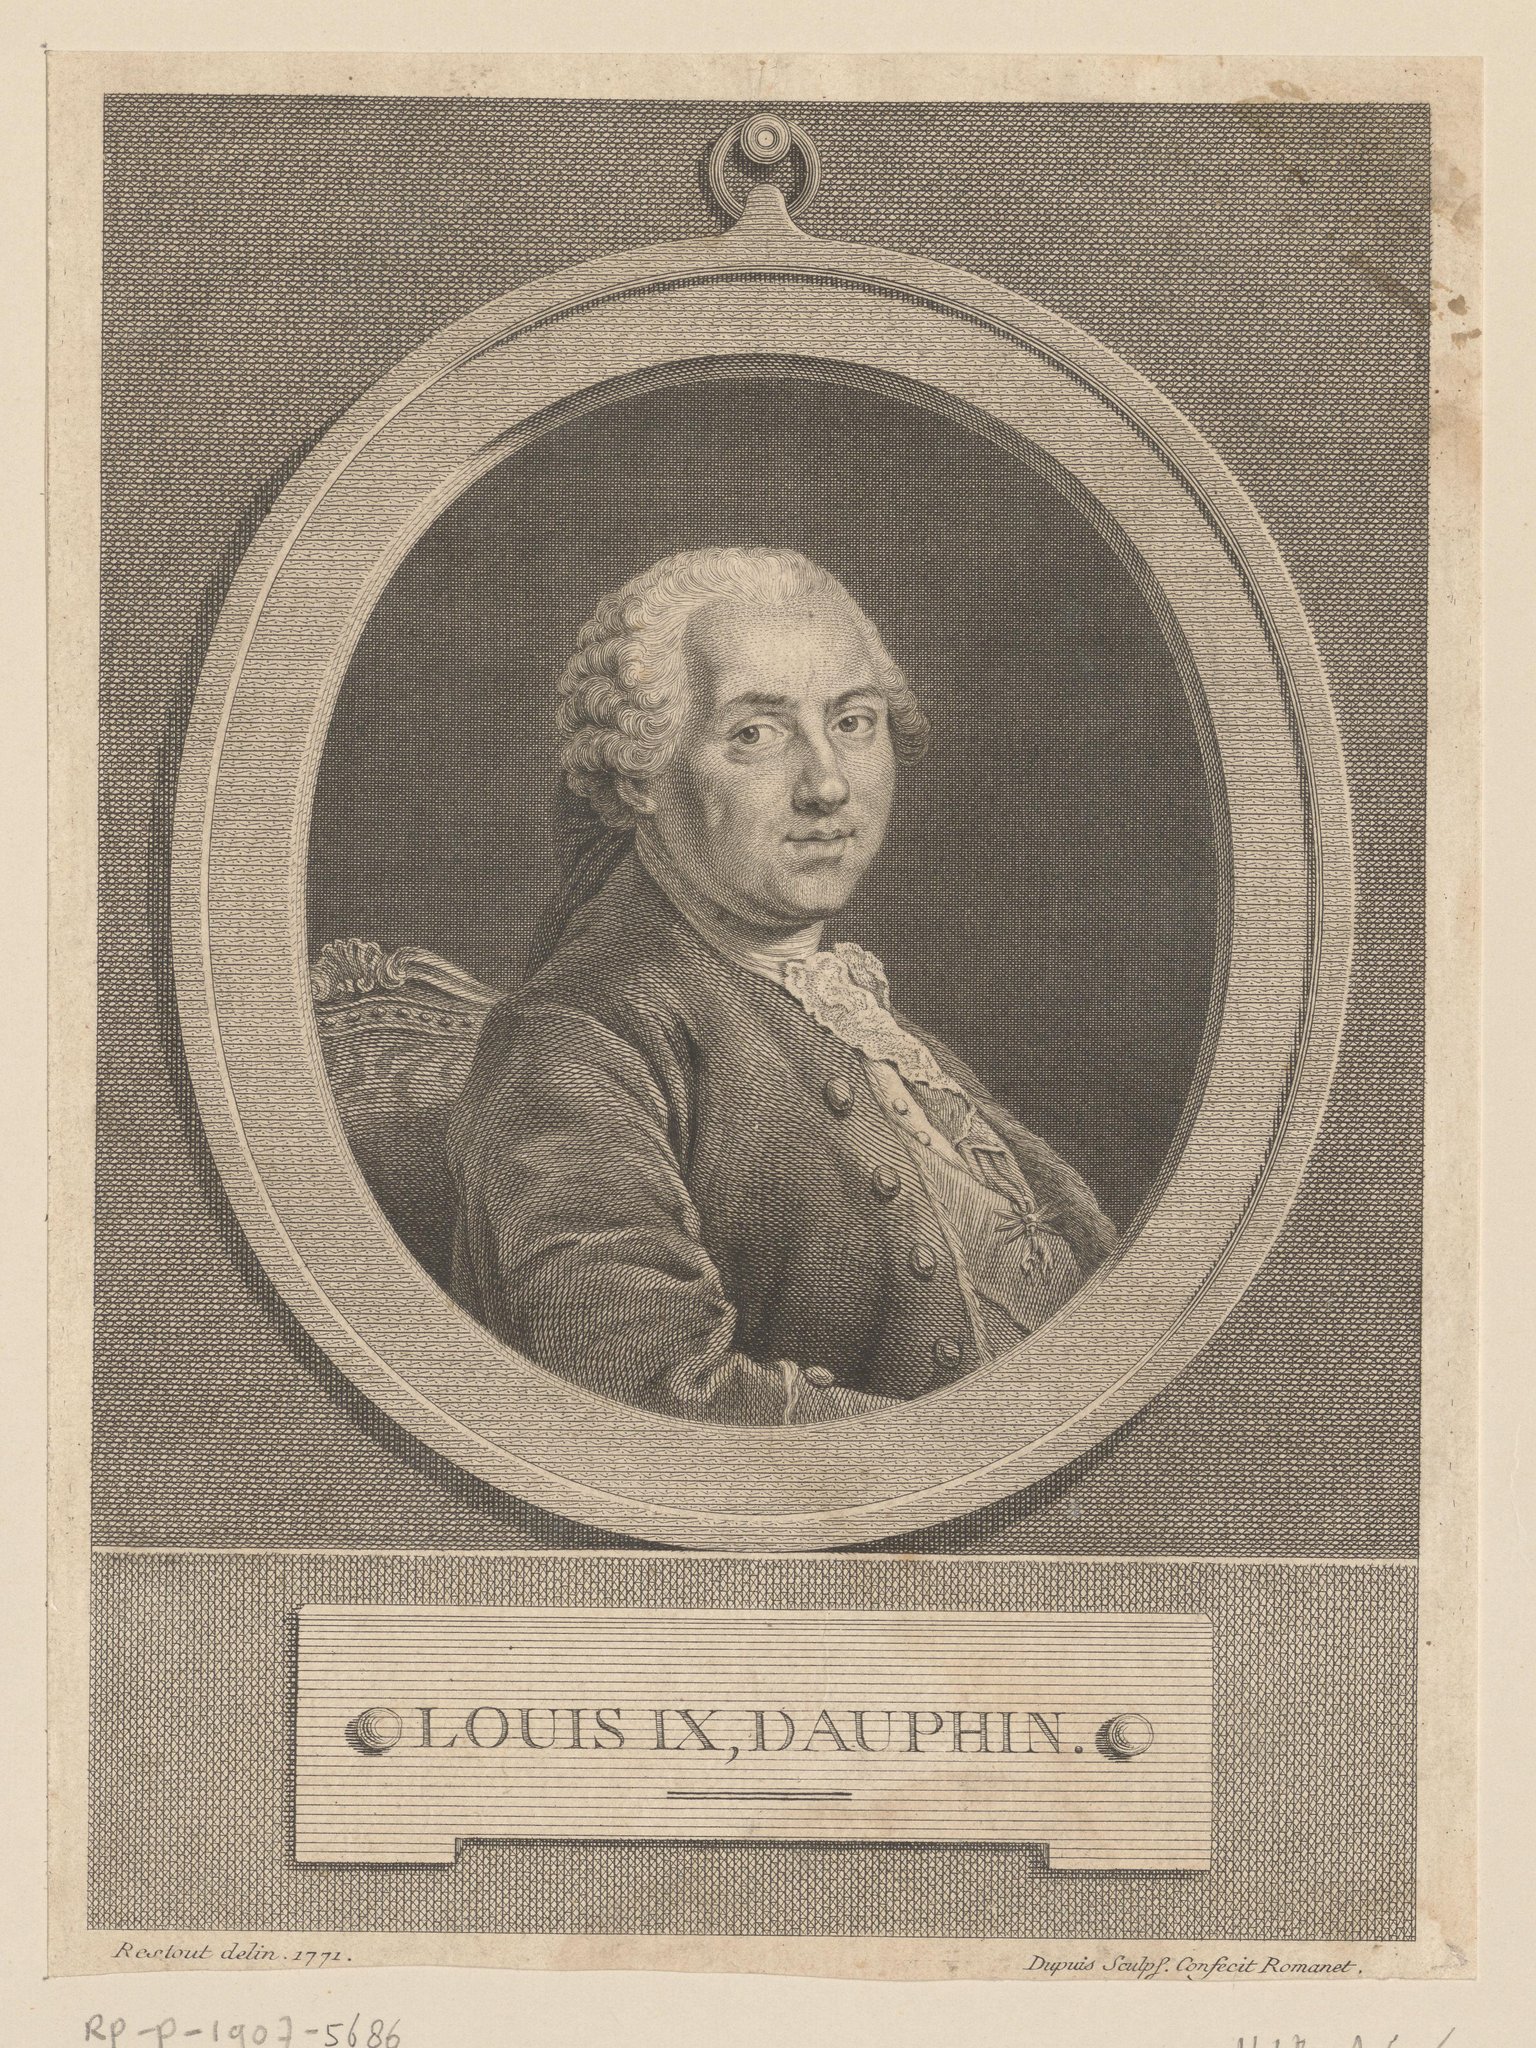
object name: print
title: Louis IX, Dauphin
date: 1771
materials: paper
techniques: engraving, etching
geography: france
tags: lodewijk van frankrijk (dauphin van frankrijk), ornament ~ medallion, historical persons, wig, knighthood order of the golden fleece - insignia of a knighthood order, e.g.: badge, chain (with name of order)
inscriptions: collector's mark: Lugt 2228